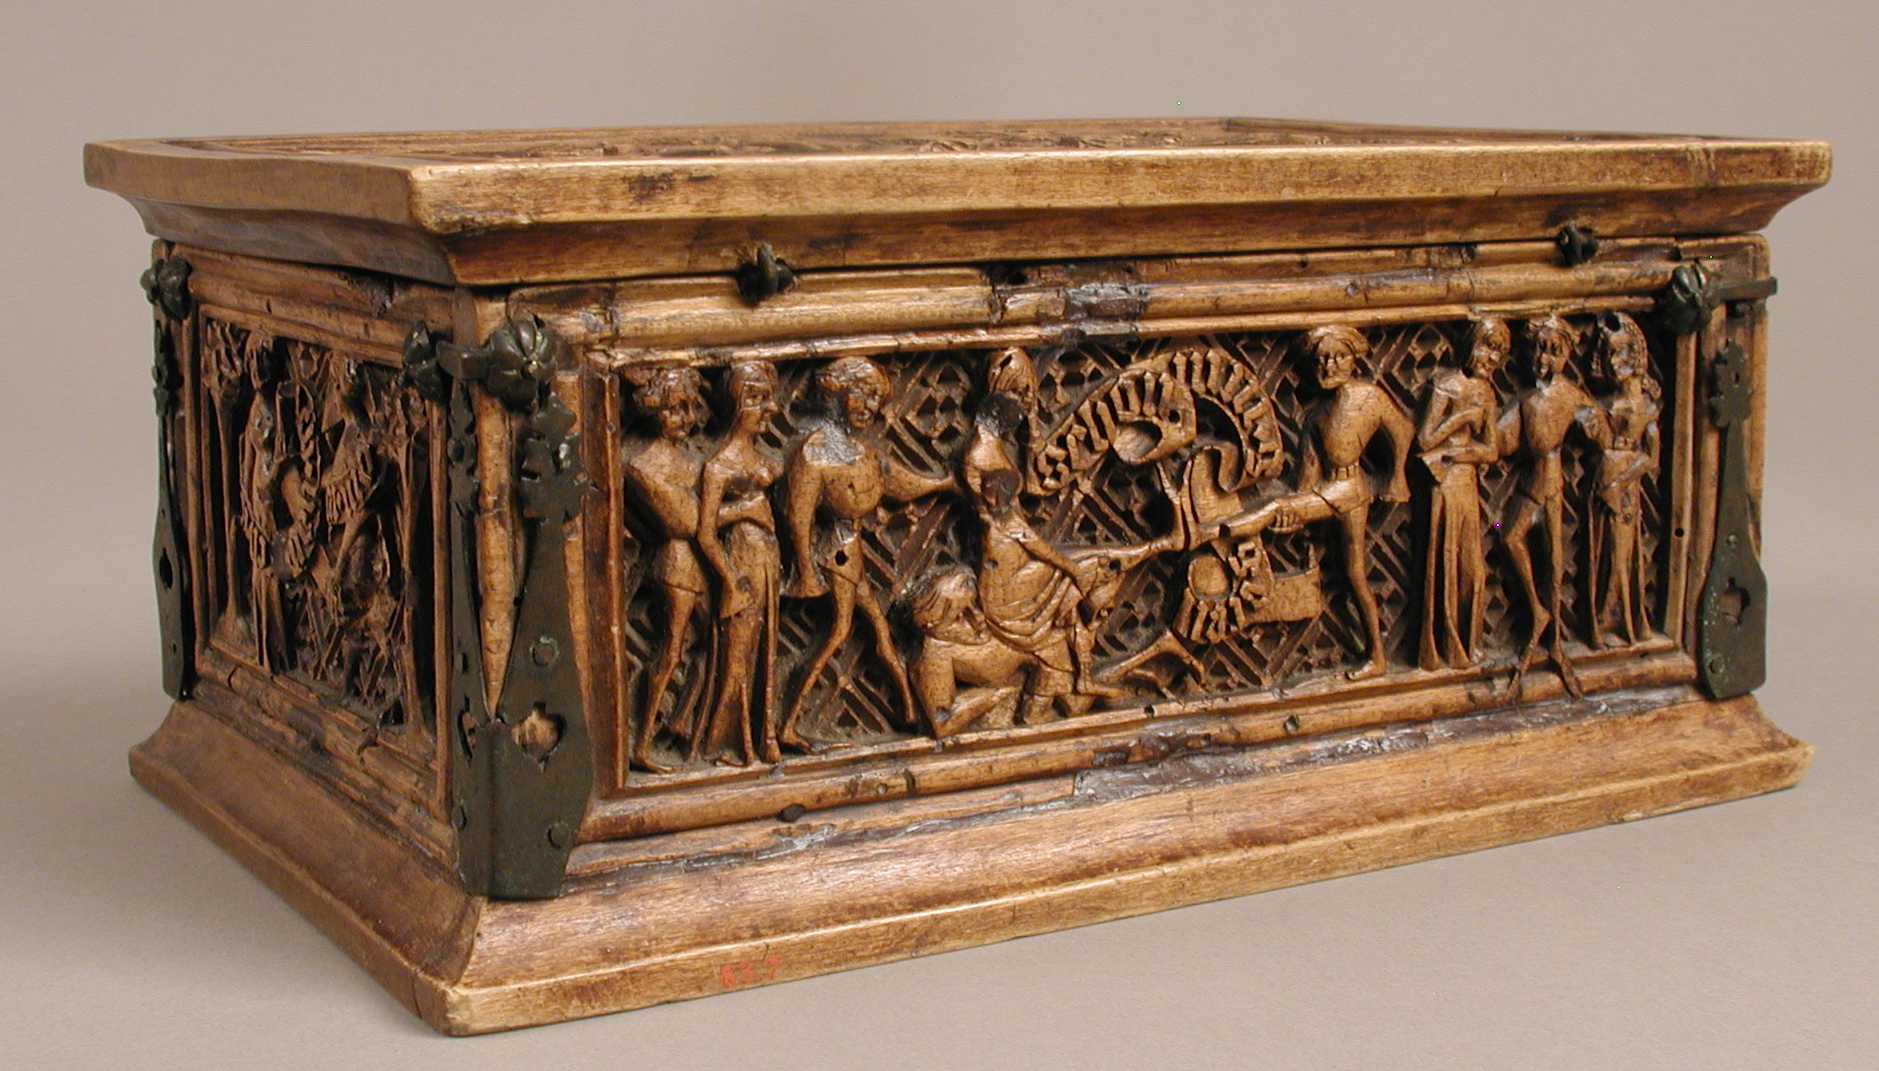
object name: casket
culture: german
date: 1367-1400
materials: copper alloy, wood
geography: france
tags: men,women